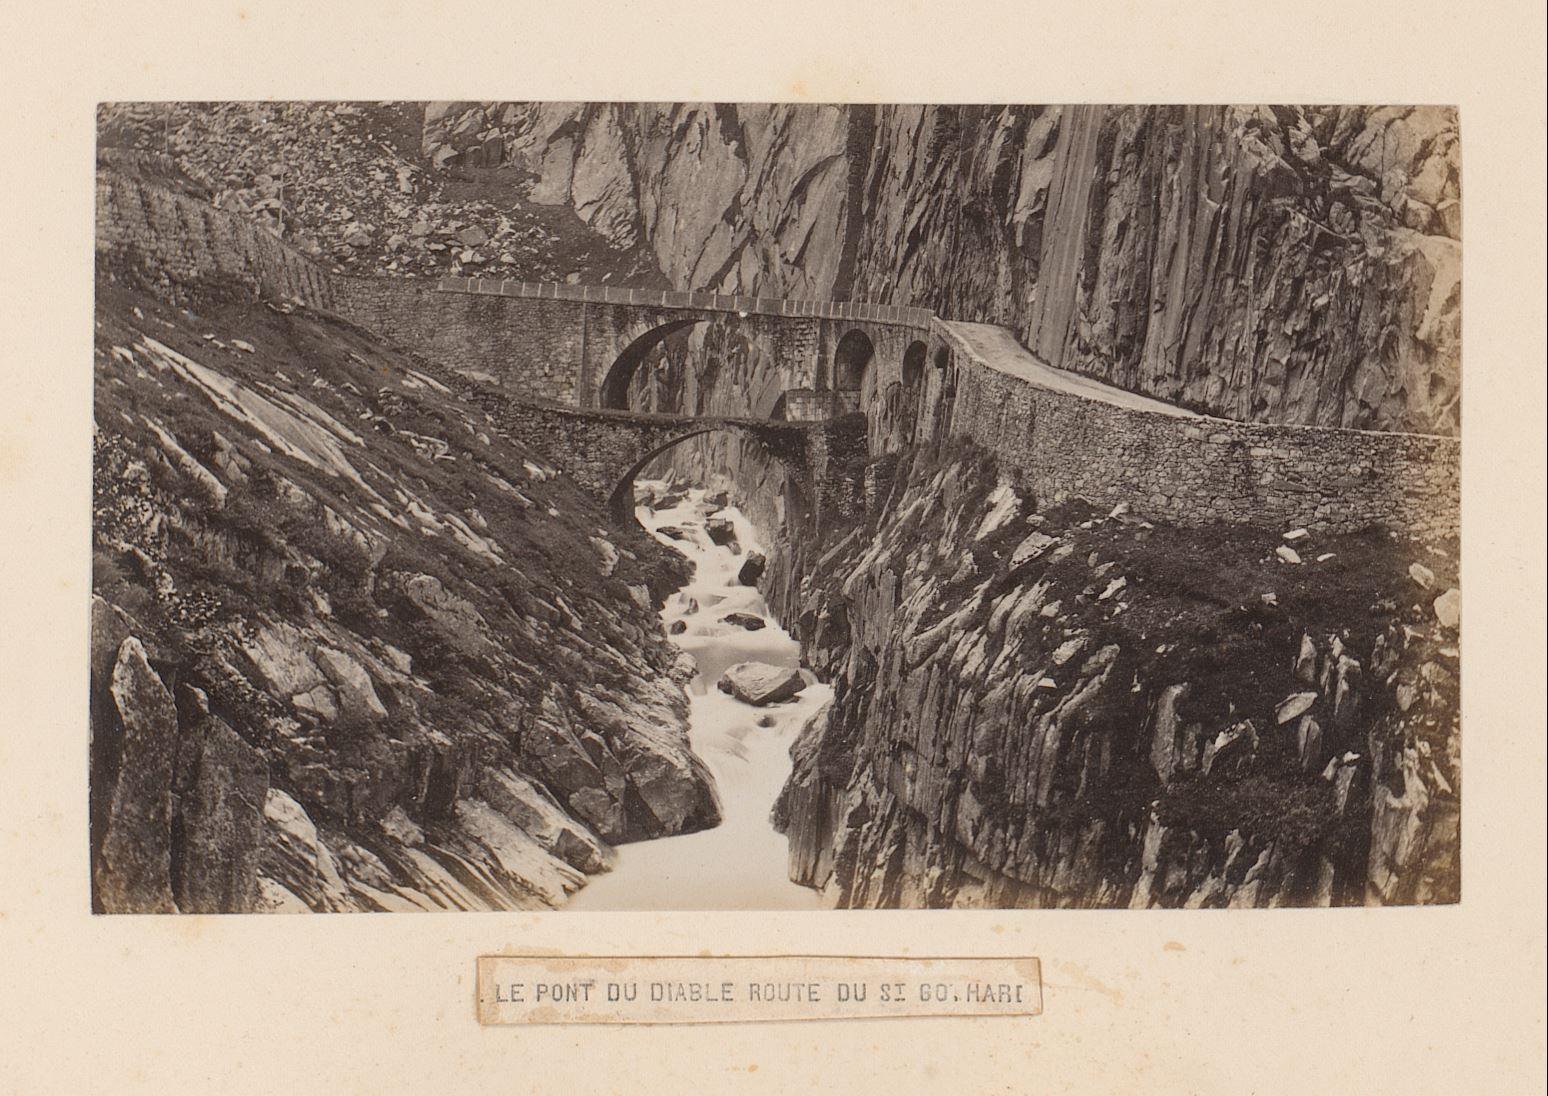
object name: photograph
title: Le Pont du Diable route du St. Go. Hart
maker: Anonymous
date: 1860-1890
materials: paper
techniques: albumen print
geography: schöllenenkloof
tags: landscape with bridge, viaduct or aqueduct, ravine, chasm, abyss, canyon